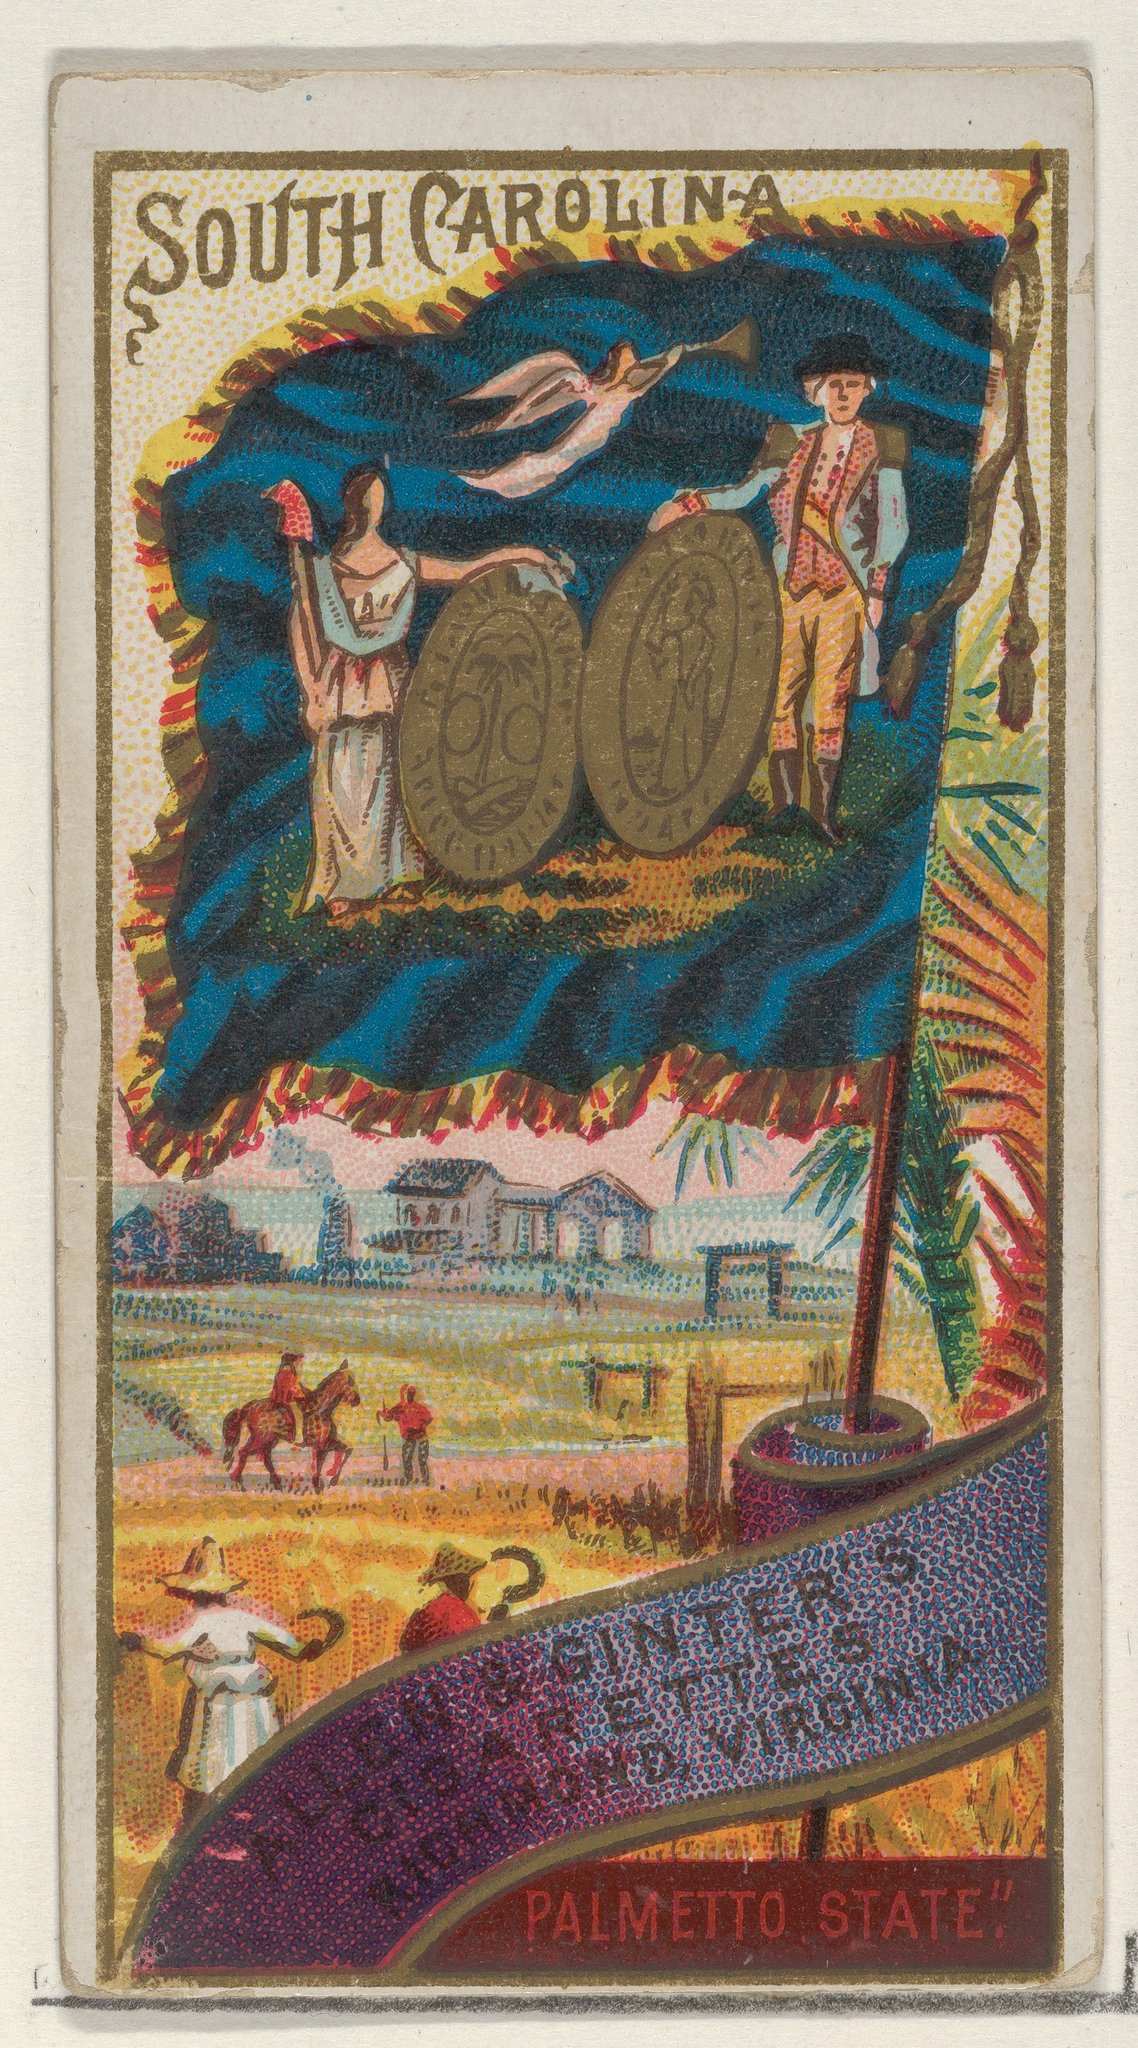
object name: print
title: South Carolina, from Flags of the States and Territories (N11) for Allen & Ginter Cigarettes Brands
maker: allen & ginter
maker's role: publisher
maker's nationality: american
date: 1888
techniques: color lithograph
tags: flags